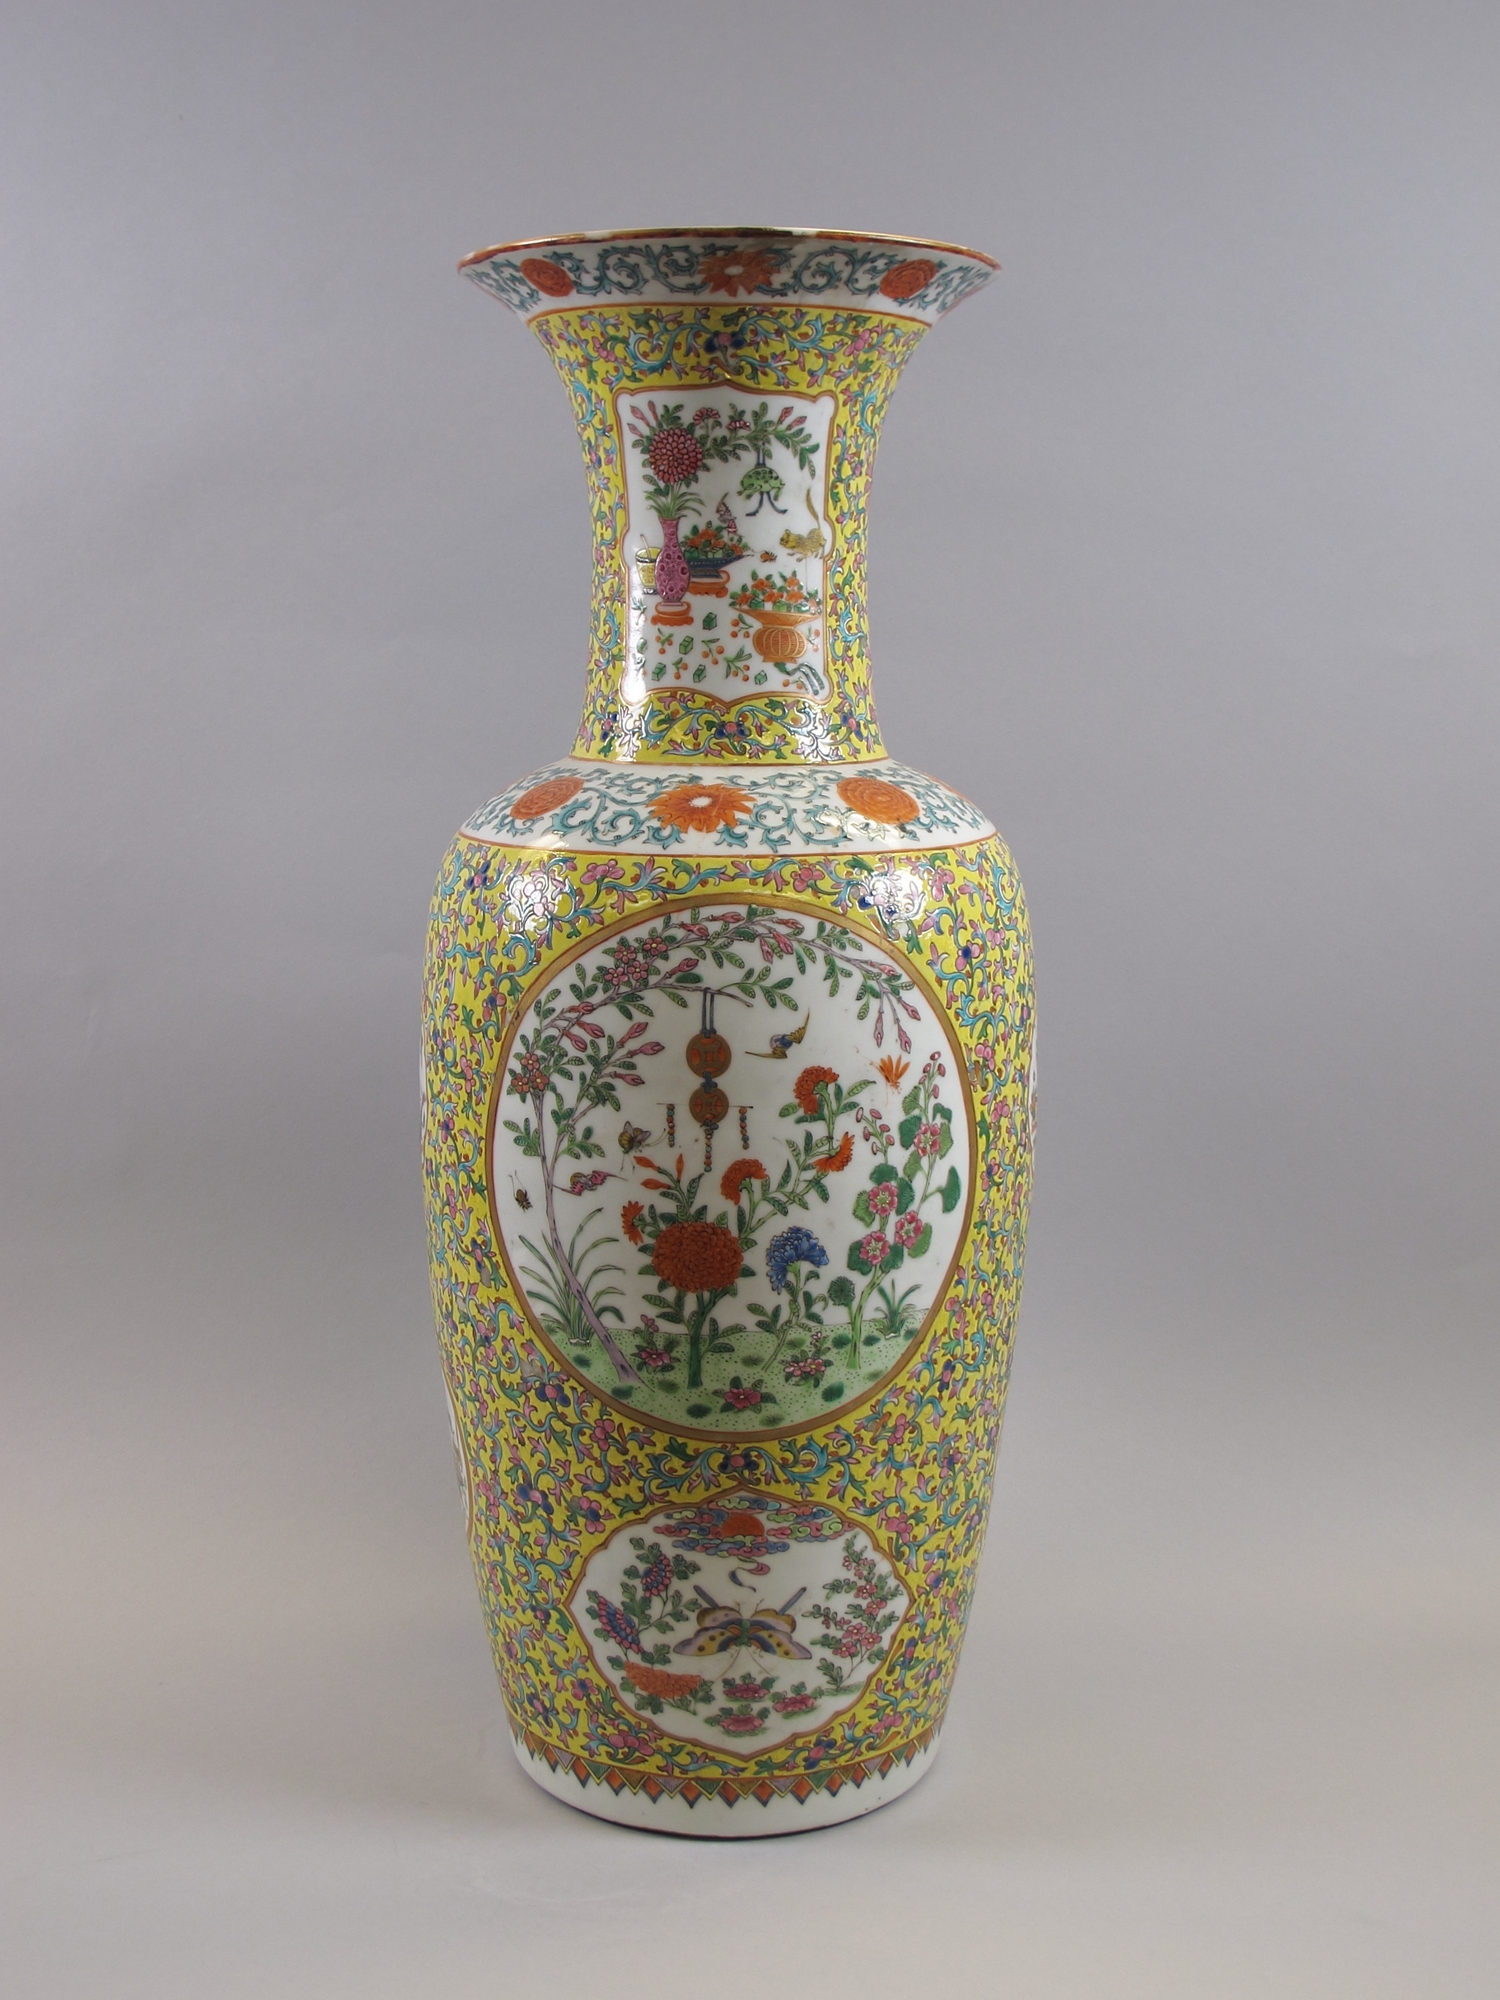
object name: vase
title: Vase with auspicious symbols of Dragon Boat Festival (Duanwu)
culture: chinese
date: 1801-1833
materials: enamel, porcelain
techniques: overglaze, painting, polychrome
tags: butterflies,flowers,leaves